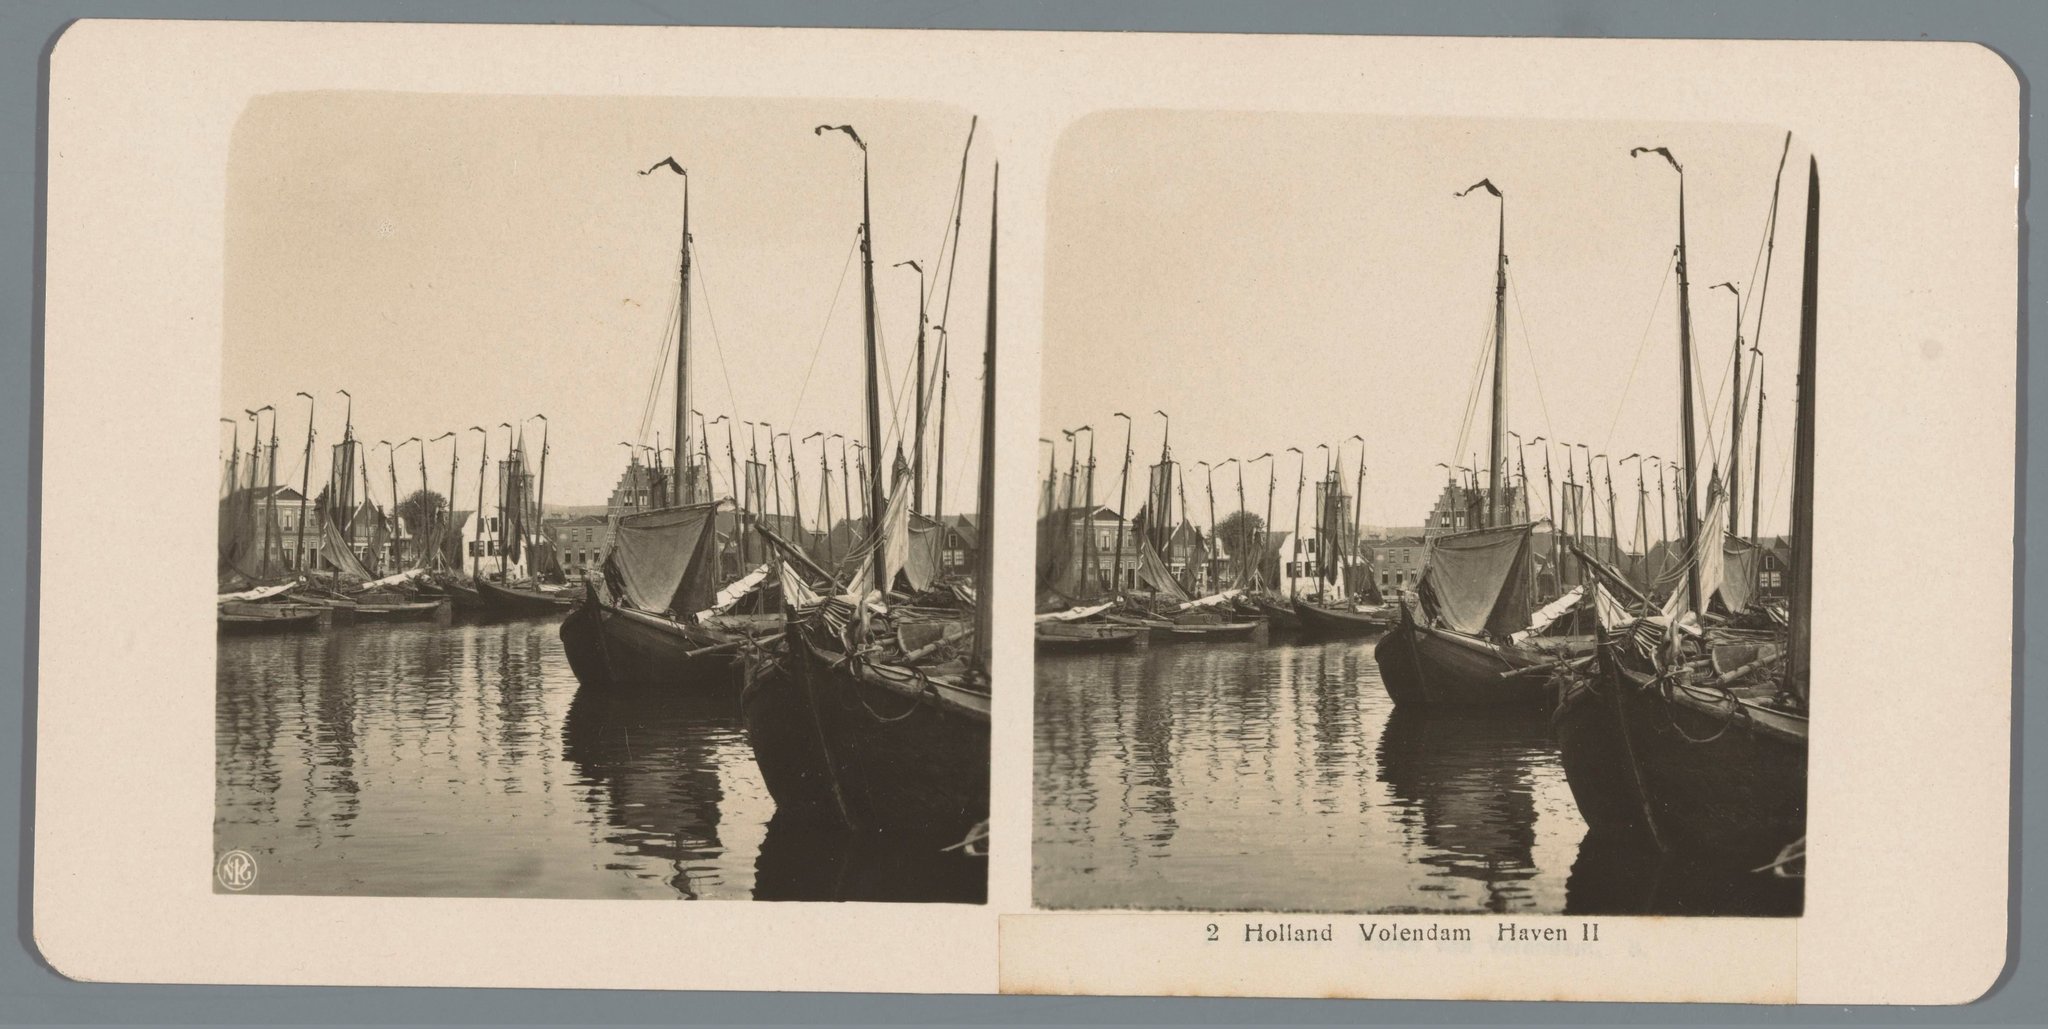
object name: stereograph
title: Boten in de haven van Volendam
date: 1900-1910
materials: cardboard, photographic support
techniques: gelatin silver print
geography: volendam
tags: harbour, ships (in general)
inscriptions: number: ‘2’, inscription: ‘NPG’